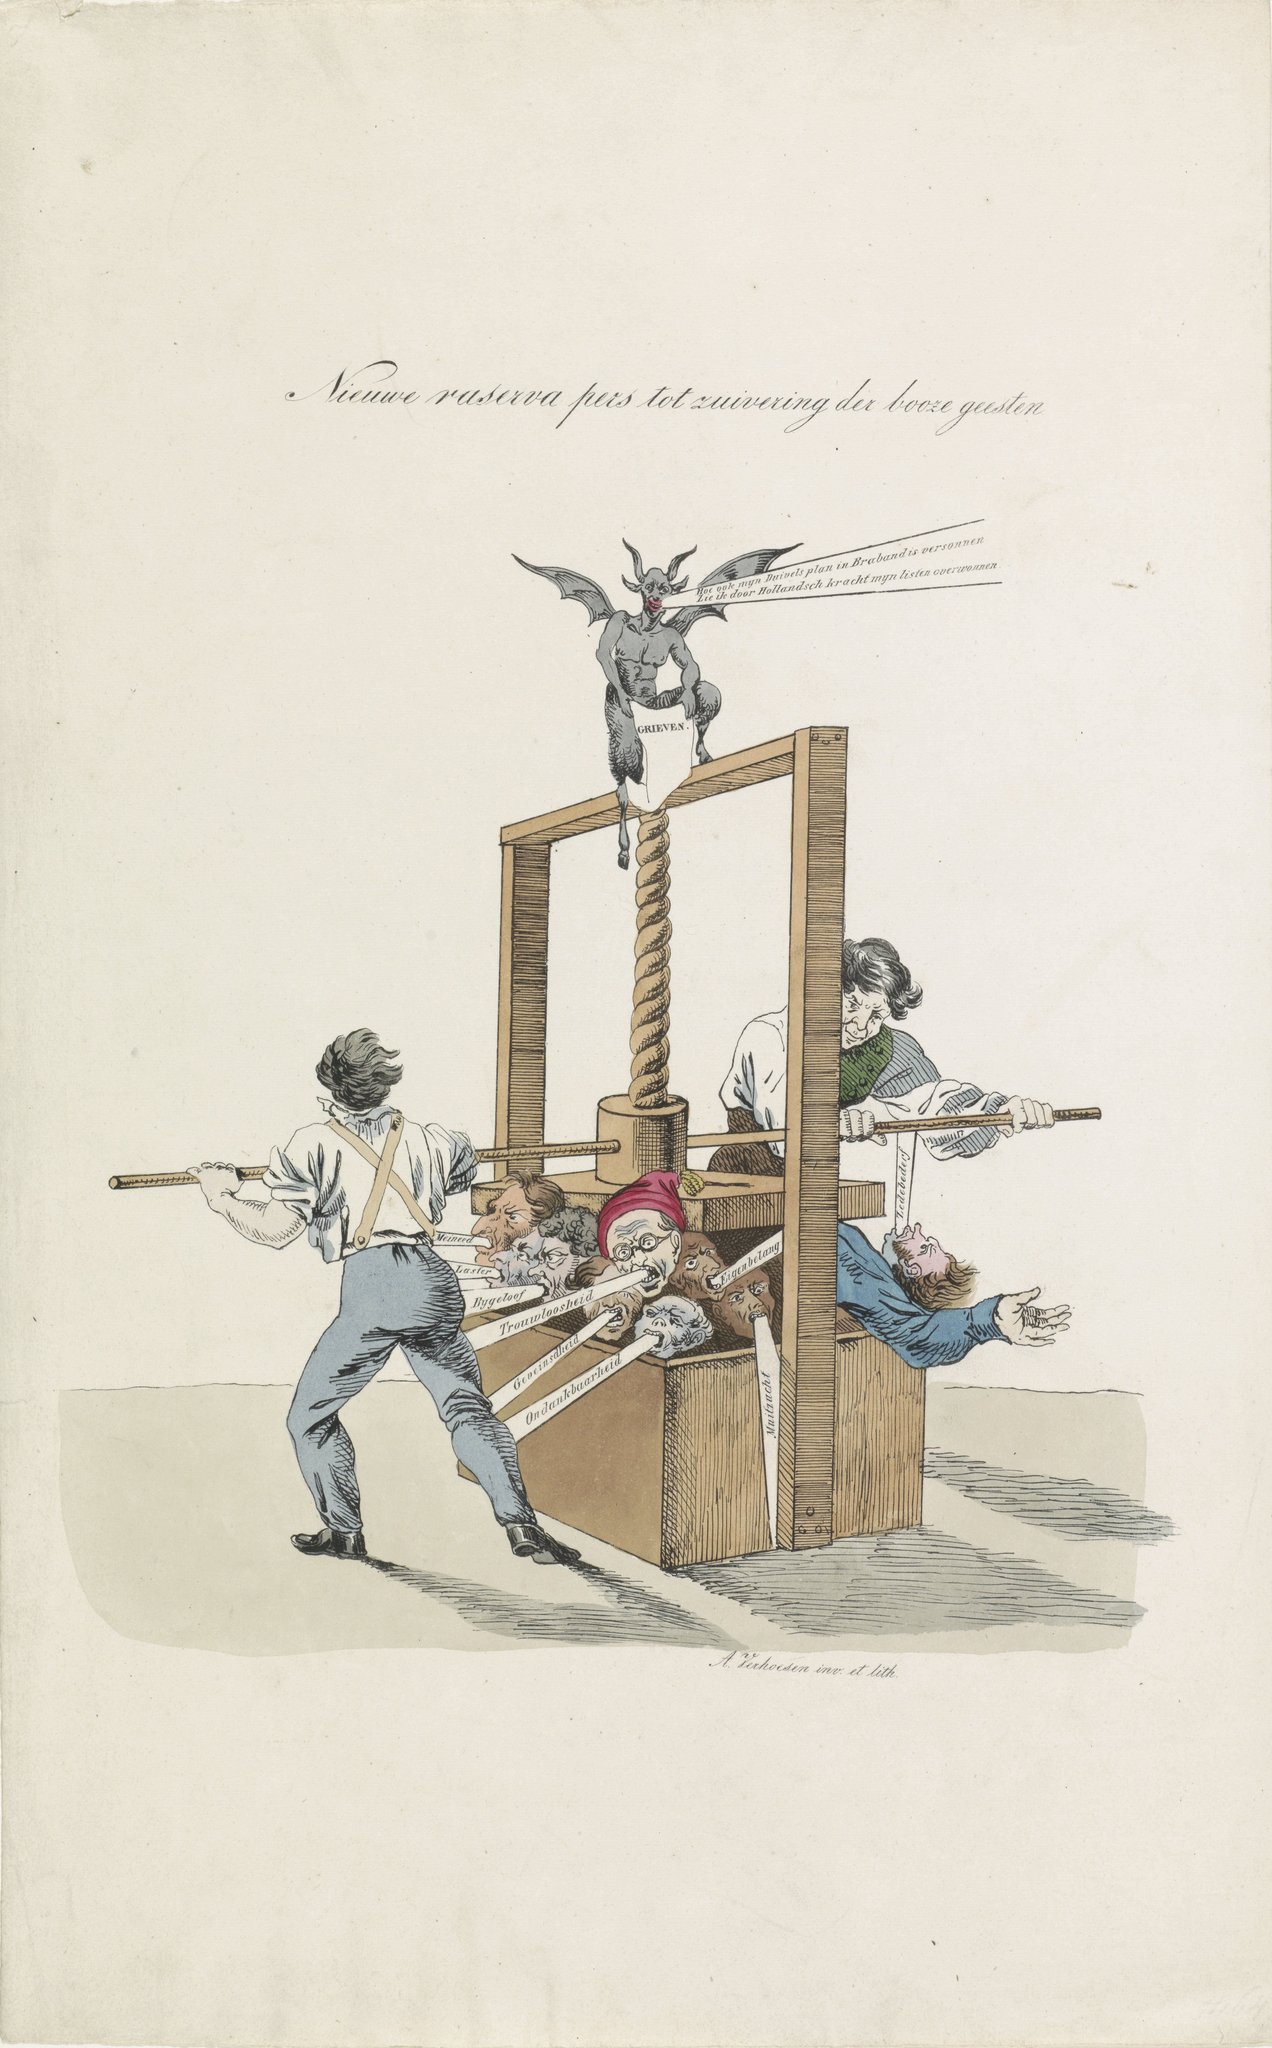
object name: cartoon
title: Nieuwe raserva pers tot zuivering der booze geesten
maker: albertus verhoesen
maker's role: draughtsman, painter, print maker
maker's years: 1806-1881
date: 1829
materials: paper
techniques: hand coloring, lithograph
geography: netherlands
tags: devil(s) and demons, printing press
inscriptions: collector's mark: Lugt 2228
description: Spotprent op de beteugeling van de losbandigheid en partijdigheid van de Belgische journalisten door een wet op vrijheid van de drukpers, naar aanleiding van een Koninklijke Boodschap van 11 december 1829. Belgische journalisten worden door twee Hollanders in een drukpers uitgeperst waarbij zij bijgeloof, laster, zedeloosheid etc. uitwasemen. Bovenop de pers zit een duivel met een lijst Grieven die zijn nederlaag tegenover de Hollandse kracht moet erkennen.